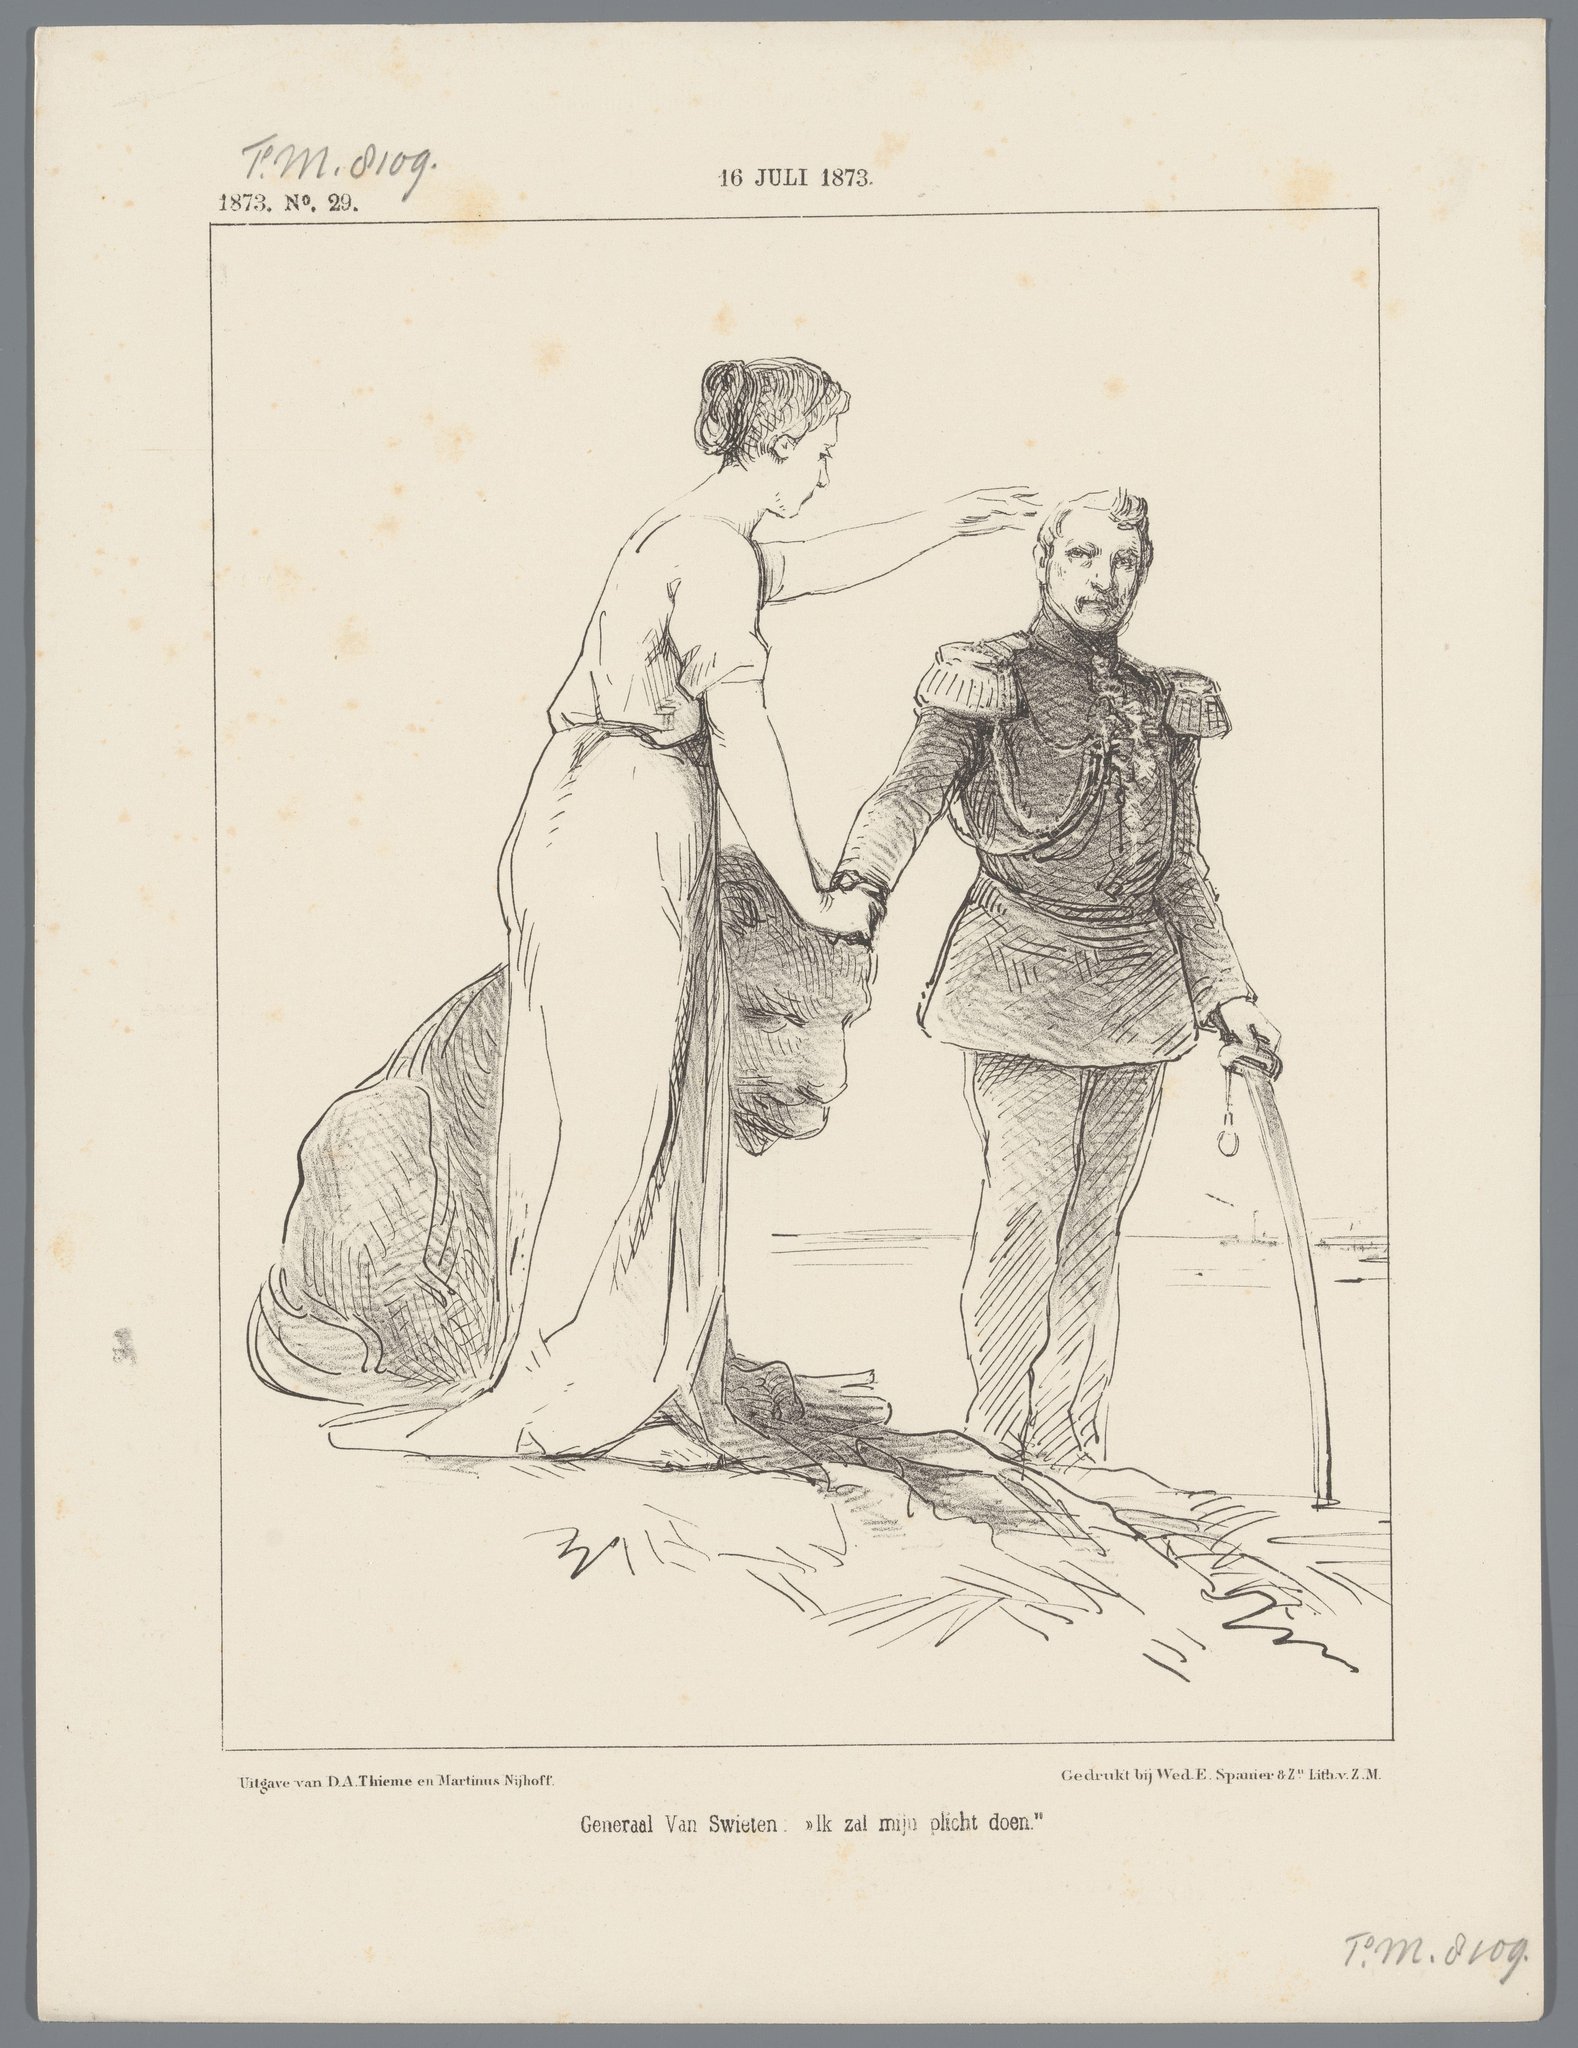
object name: print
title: Het vertrek van generaal van Swieten naar Atjeh, 1873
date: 1873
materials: paper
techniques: lithograph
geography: netherlands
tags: militair, jan van swieten, atjeh, eerste atjehexpeditie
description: Het vertrek van generaal Jan van Swieten naar Atjeh op 16 juli 1873. Plaat verschenen bij het weekblad De Nederlandsche Spectator, nr. 29, 1873.